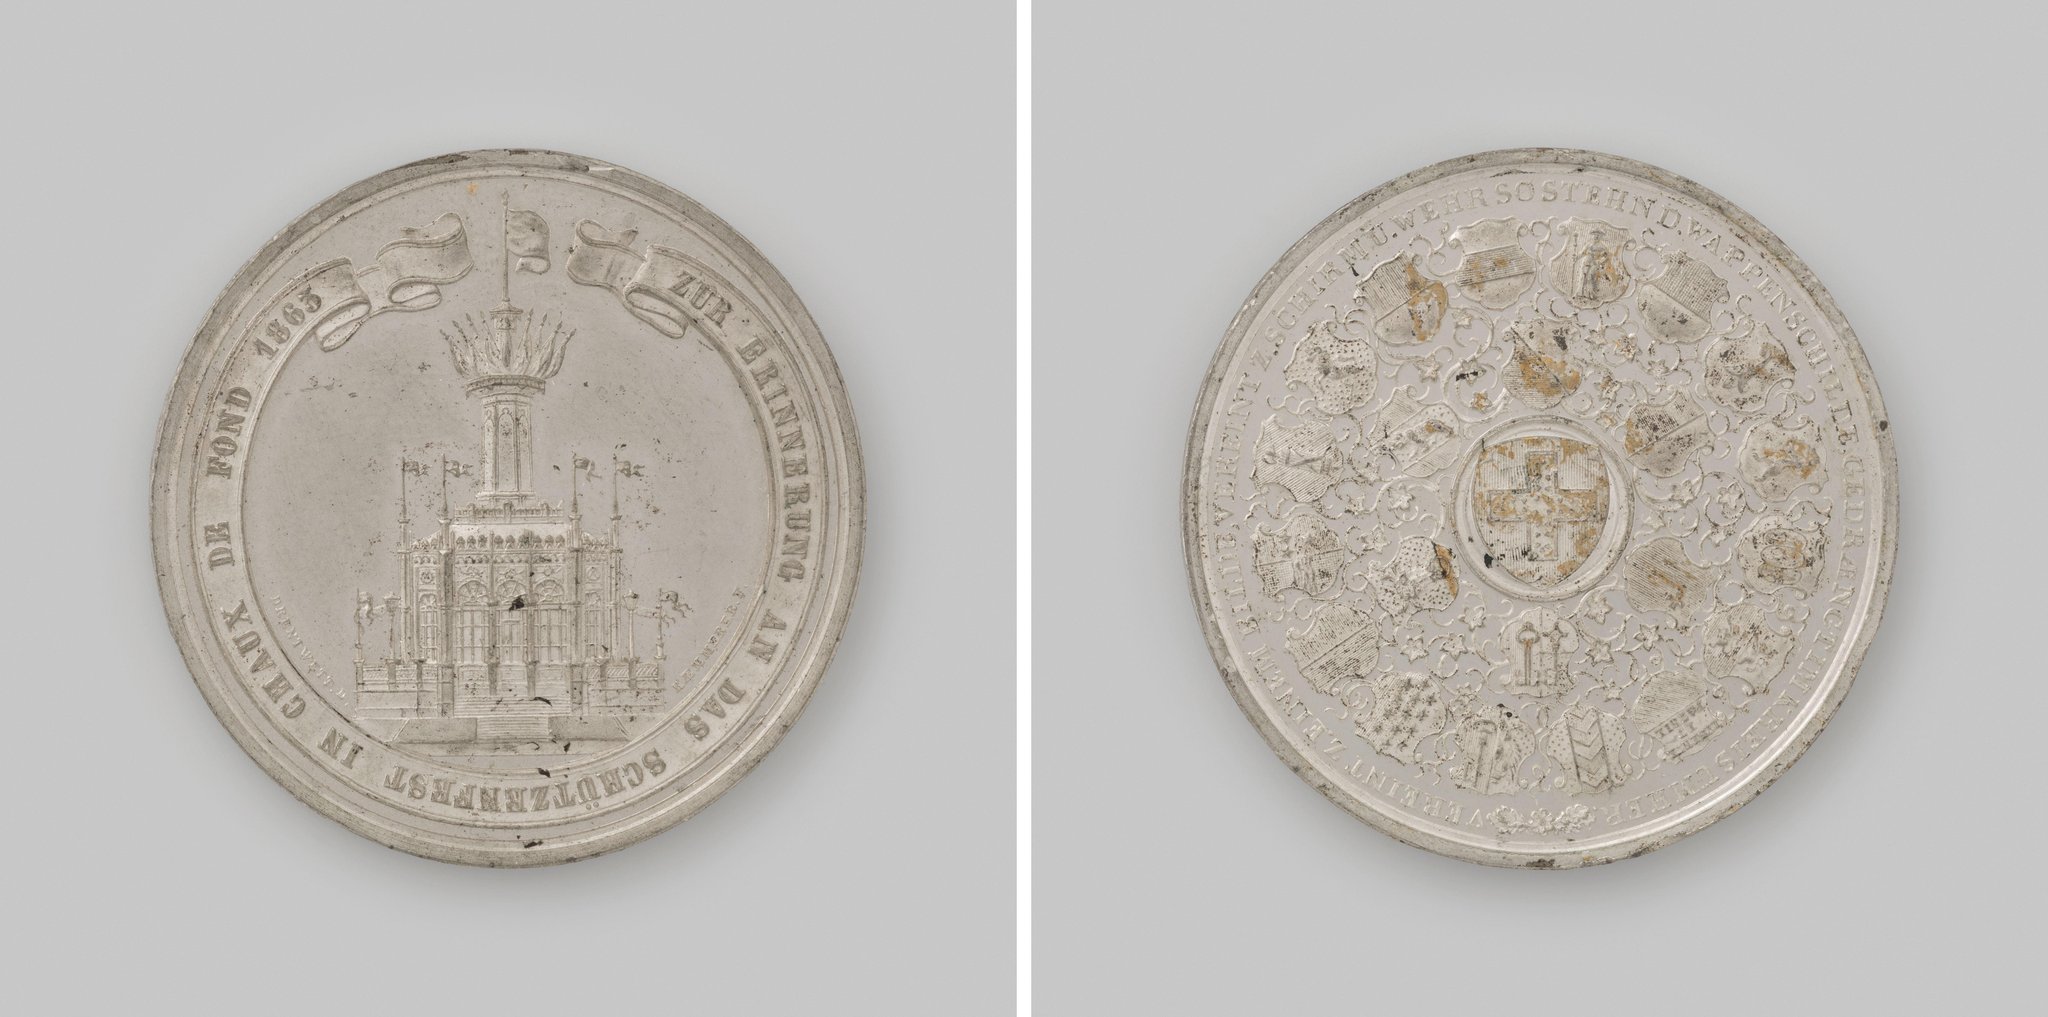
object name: marksman medal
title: Eidgenossisches Freischiessen te Chaux de Fonds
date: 1863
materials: silver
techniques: striking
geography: augsburg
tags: la chaux-de-fonds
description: Zilveren penning. Voorzijde: feesthal, versierd met vaandels binnen omschrift op wimpel. Keerzijde: medaillon met wapenschild, omgeven door rand van zes en rand van zestien met klimop verbonden wapenschilden binnen omschrift